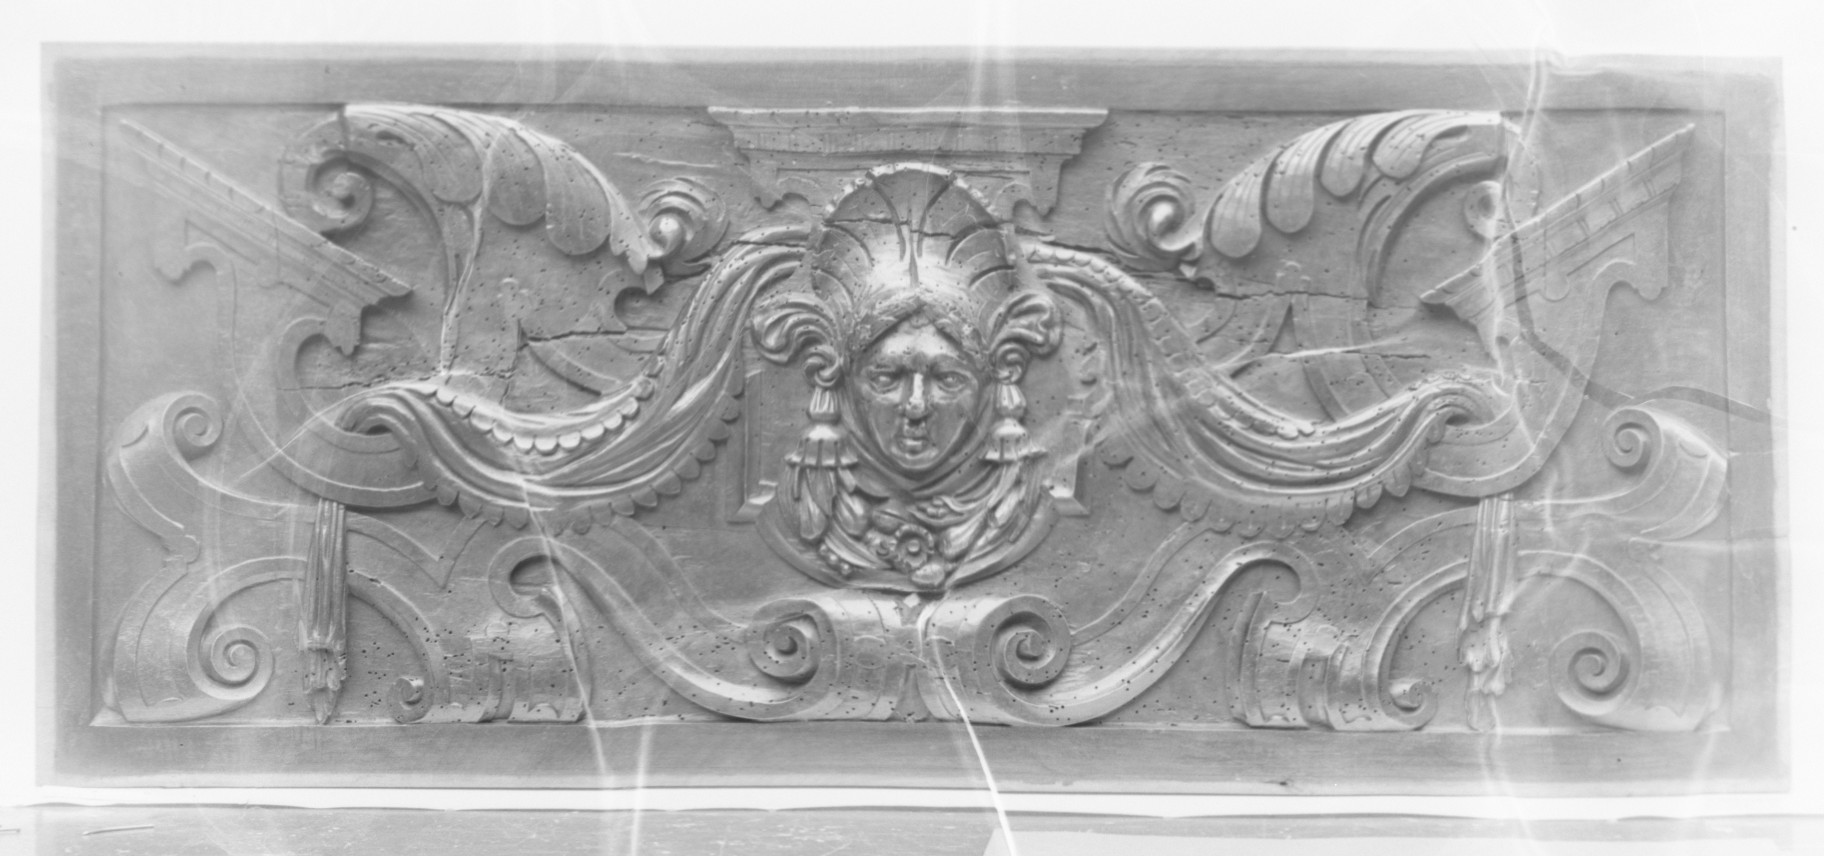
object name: panel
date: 1501-1600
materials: wood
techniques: carving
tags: faces